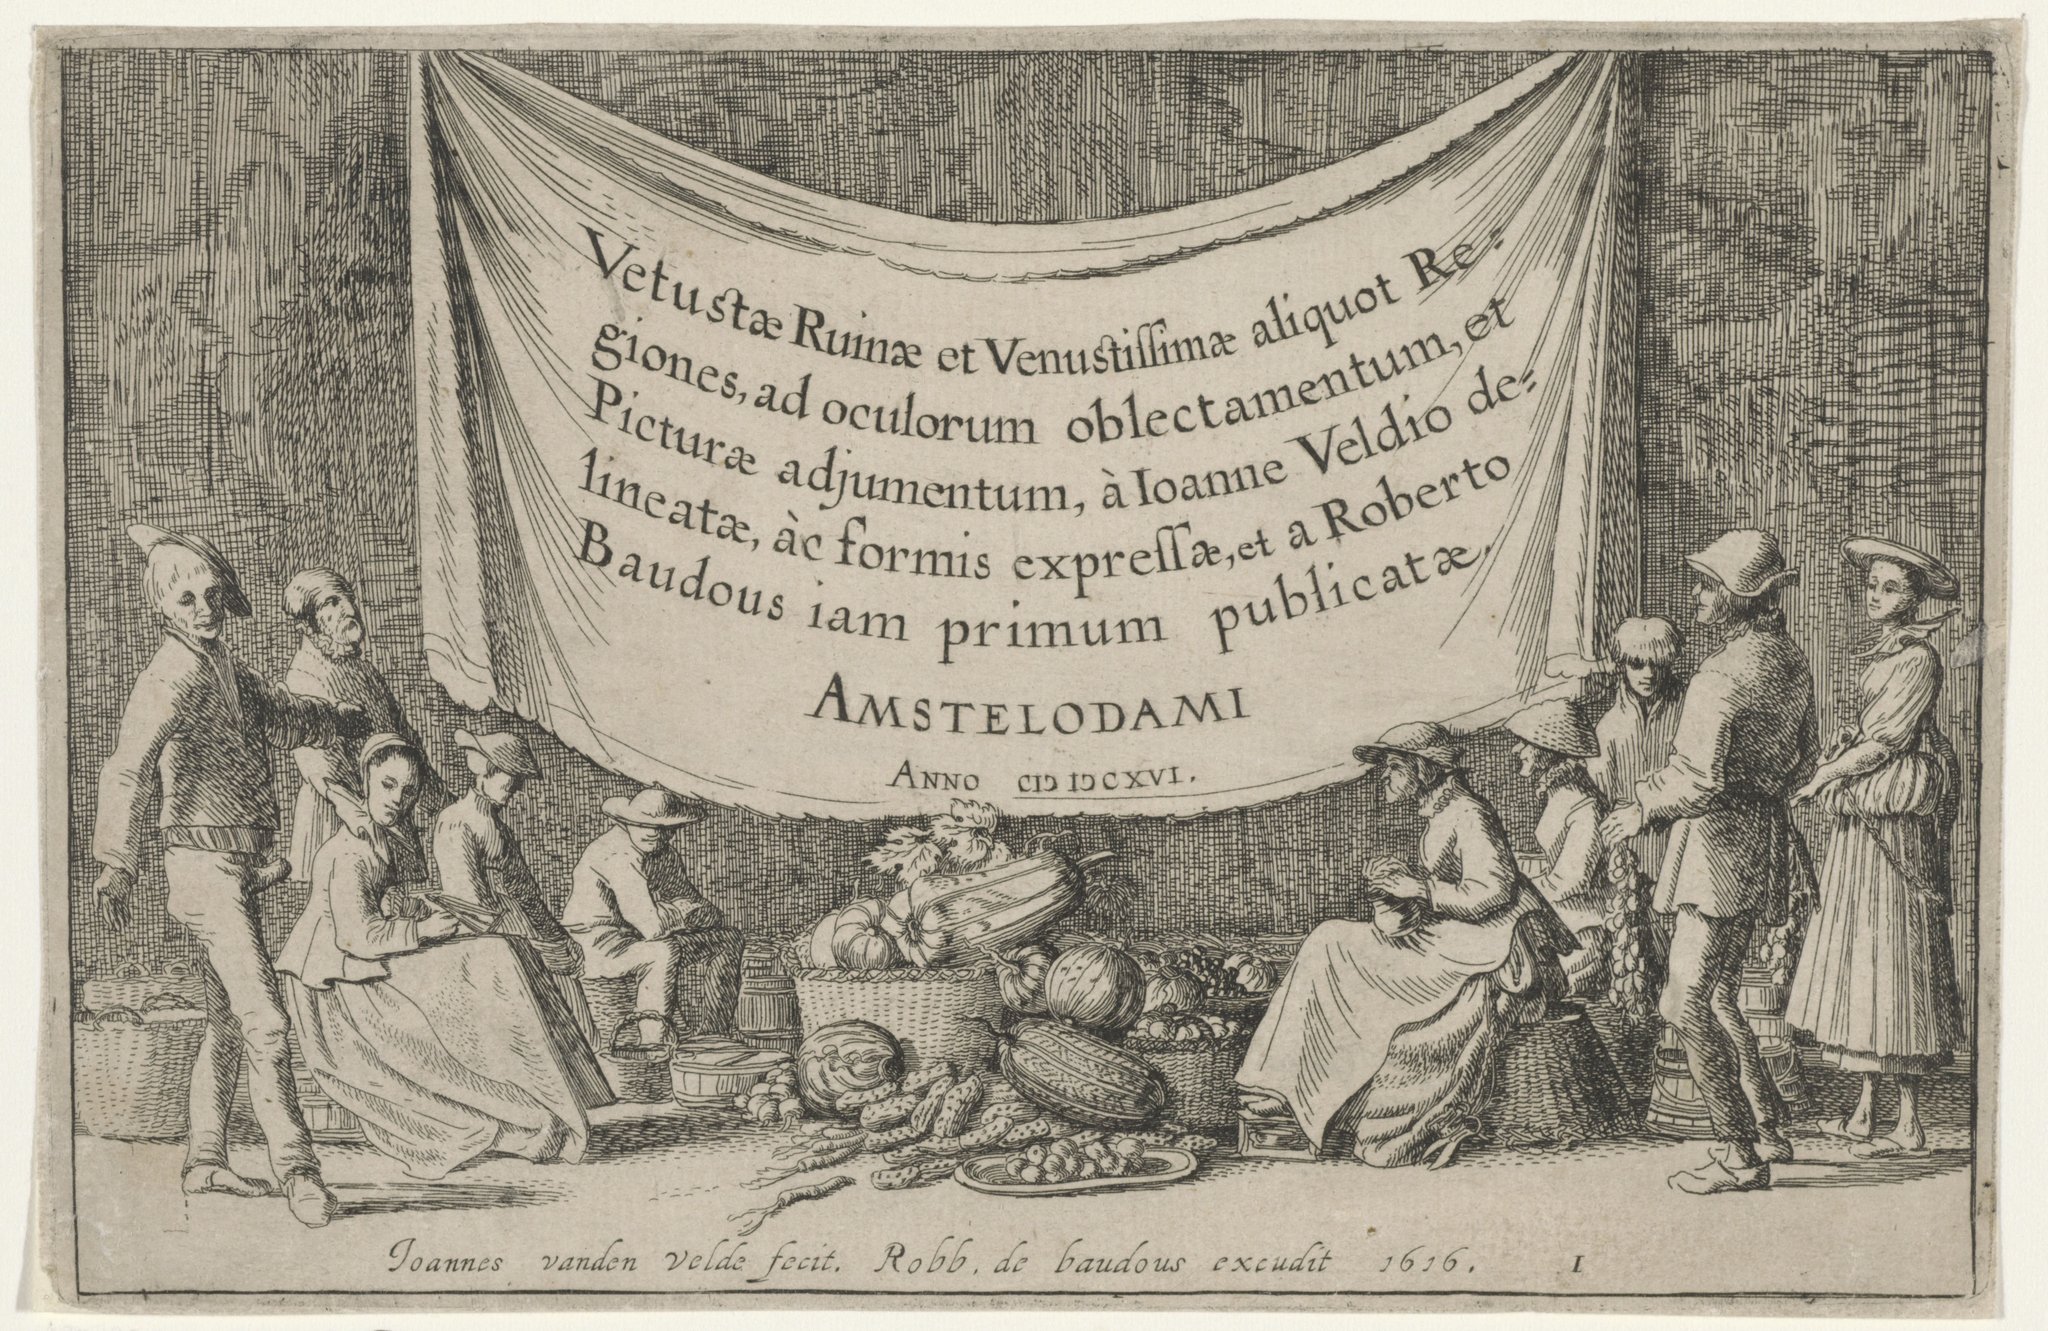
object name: titelprent, frontispice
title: Figuren bij manden met vruchten en goenten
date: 1616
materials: paper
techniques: etching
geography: northern netherlands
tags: vegetables, plants cultivated for their edible roots or tubers, e.g. potato, turnip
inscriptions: collector's mark: Lugt 964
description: Figuren bij manden met vruchten en groenten, onder een doek waarop de titel. Titelprent van een serie van zestien.